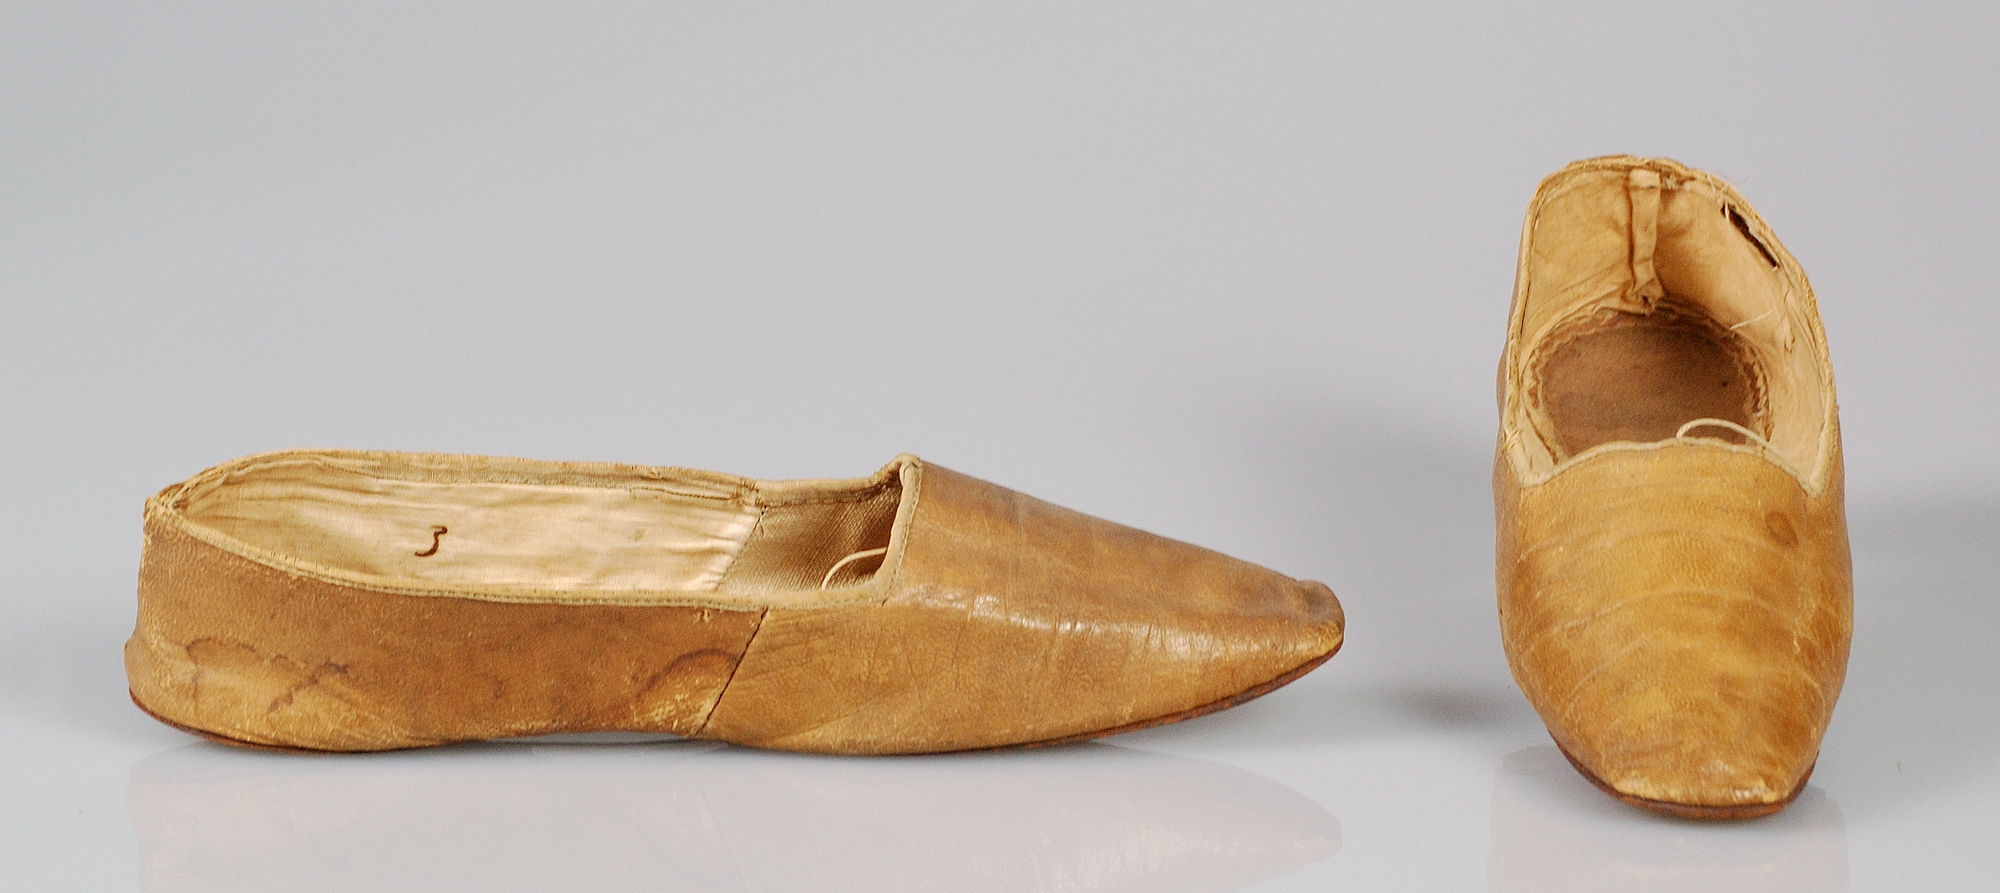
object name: slipper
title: Slippers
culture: british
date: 1828-1832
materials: leather